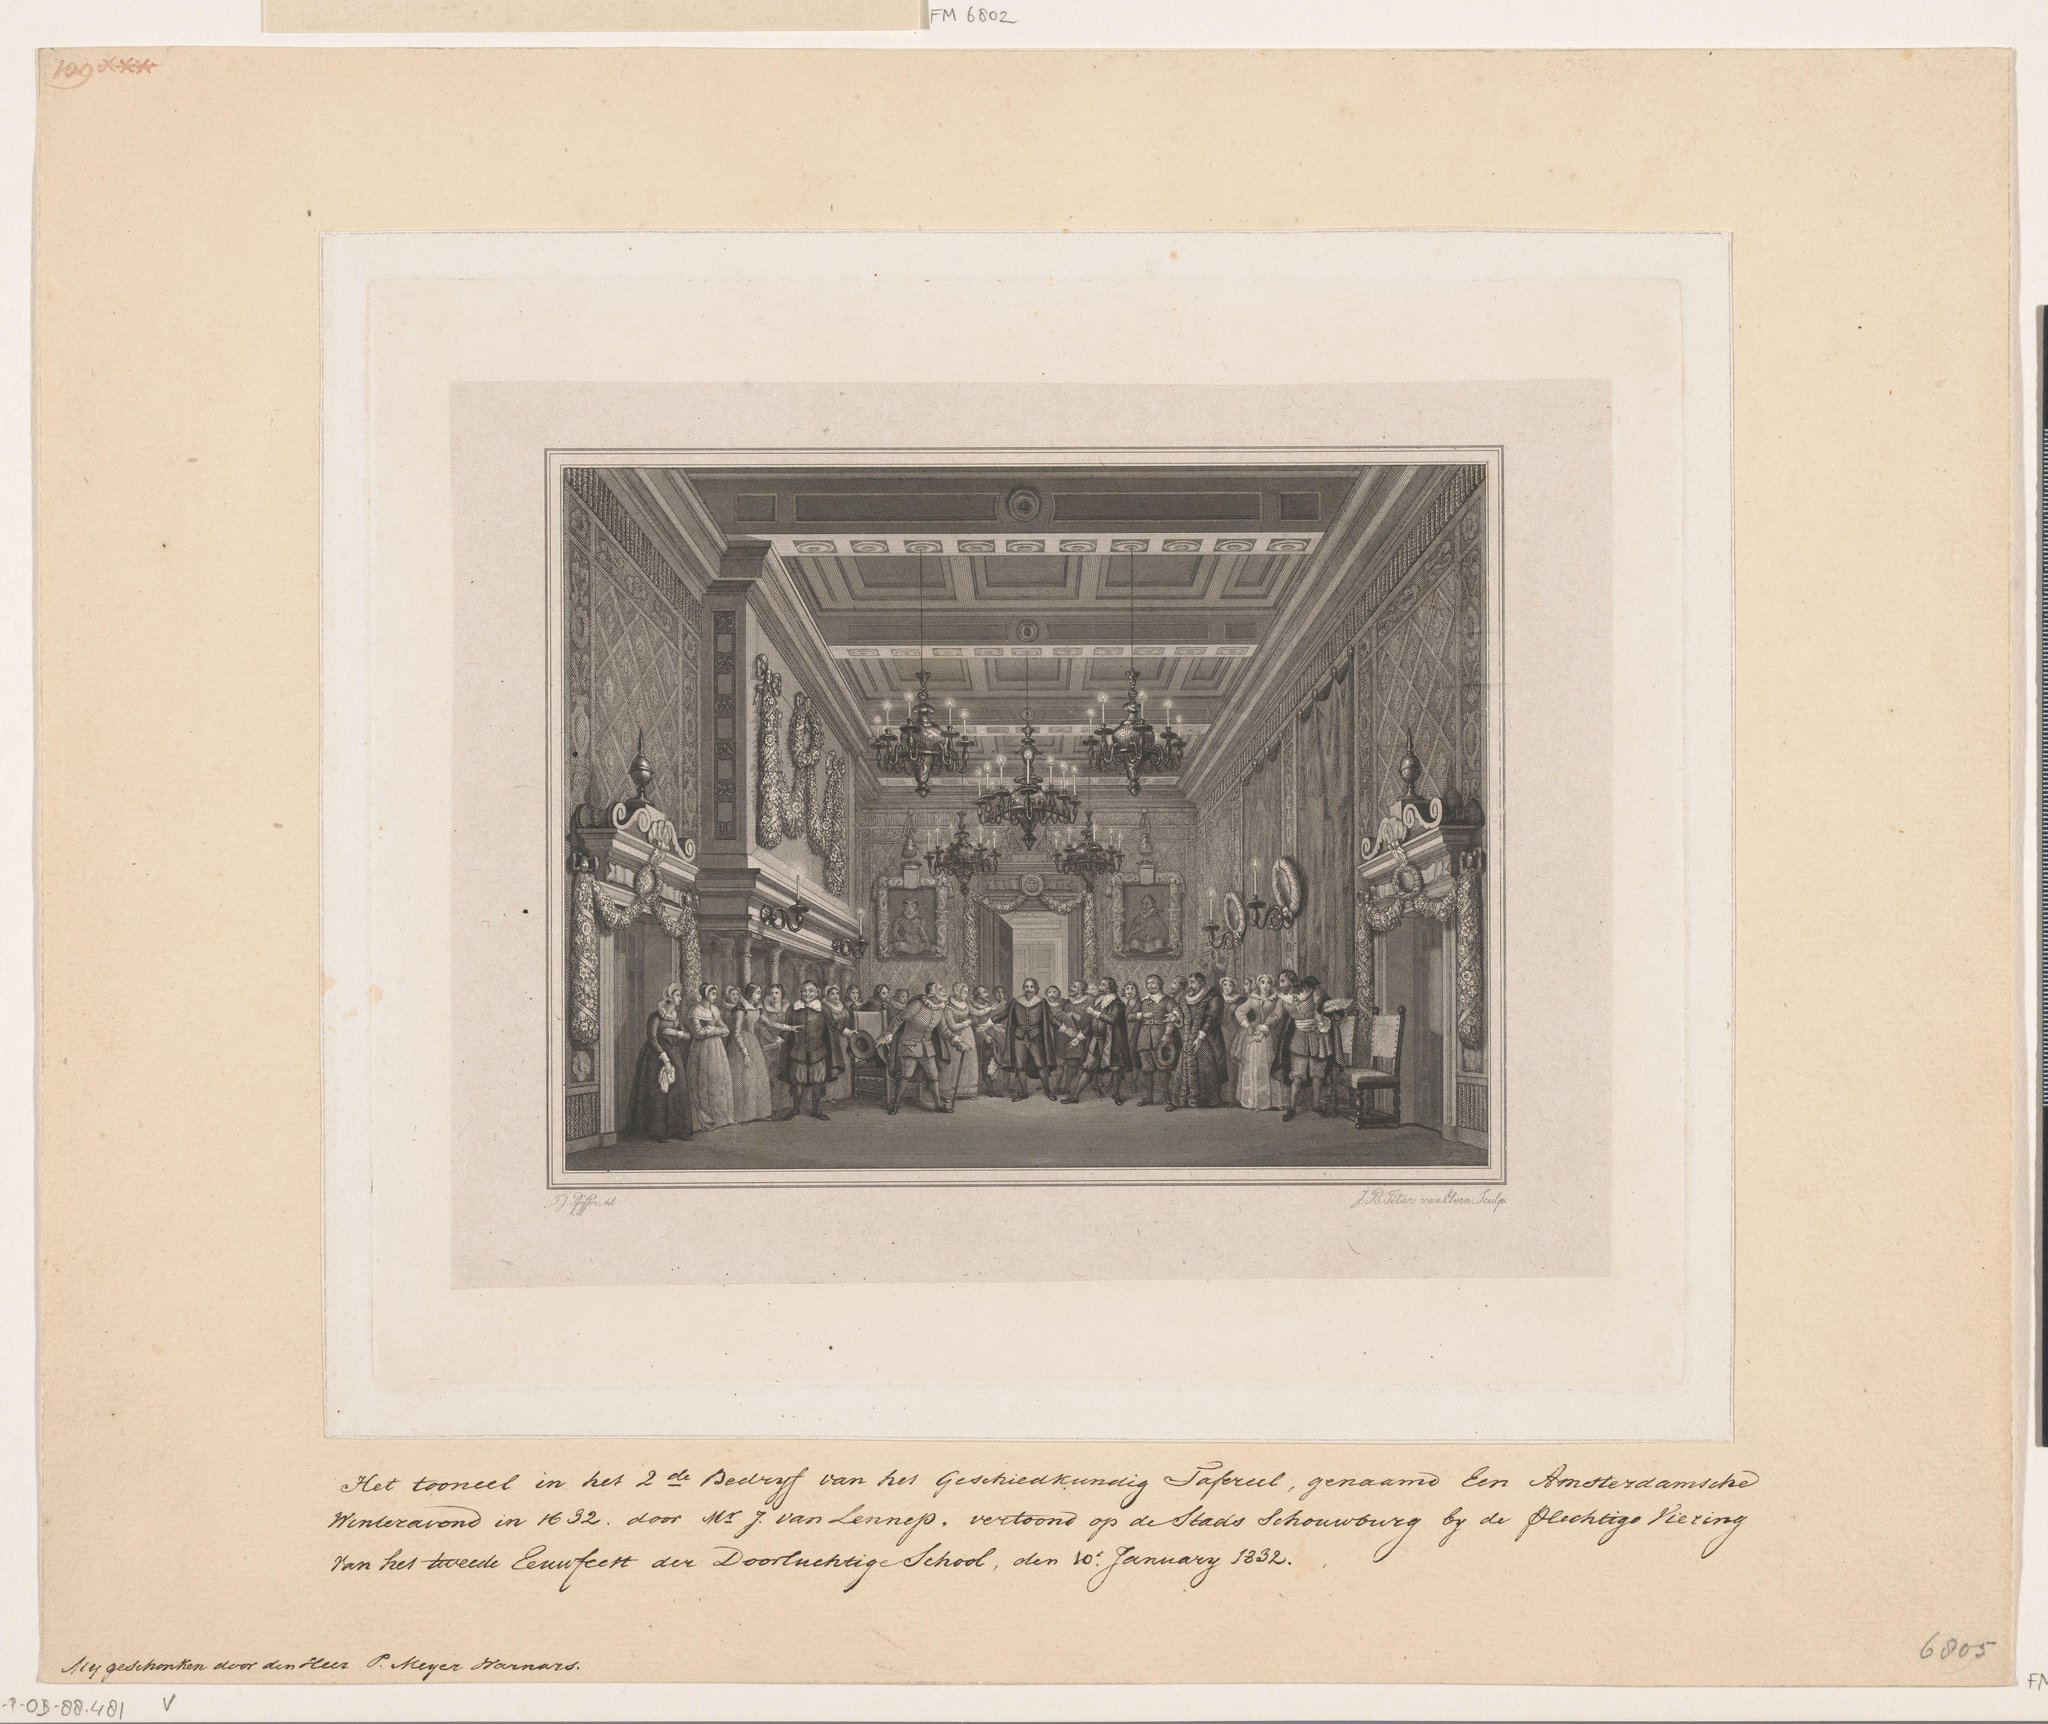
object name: print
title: Toneelvoorstelling op het tweede eeuwfeest van het Athenaeum Illustre te Amsterdam, 1832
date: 1832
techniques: printmaking, engraving, etching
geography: netherlands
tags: group of actors, troupe; actors on the stage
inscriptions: collector's mark: Lugt 2228, inscription: ‘Het tooneel in het 2de Bedrijf ...10 January 1832. / Mij geschonken door den Heer P. Meyer Warnars.’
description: Toneelvoorstelling van het geschiedkundig tafereel 'Een Amsterdamsche winteravond in 1632', door mr. Jacob van Lennep. Ter gelegenheid van het tweede eeuwfeest (1632-1832) van het Athenaeum Illustre te Amsterdam, in de Stadsschouwburg te Amsterdam, 10 januari 1832.